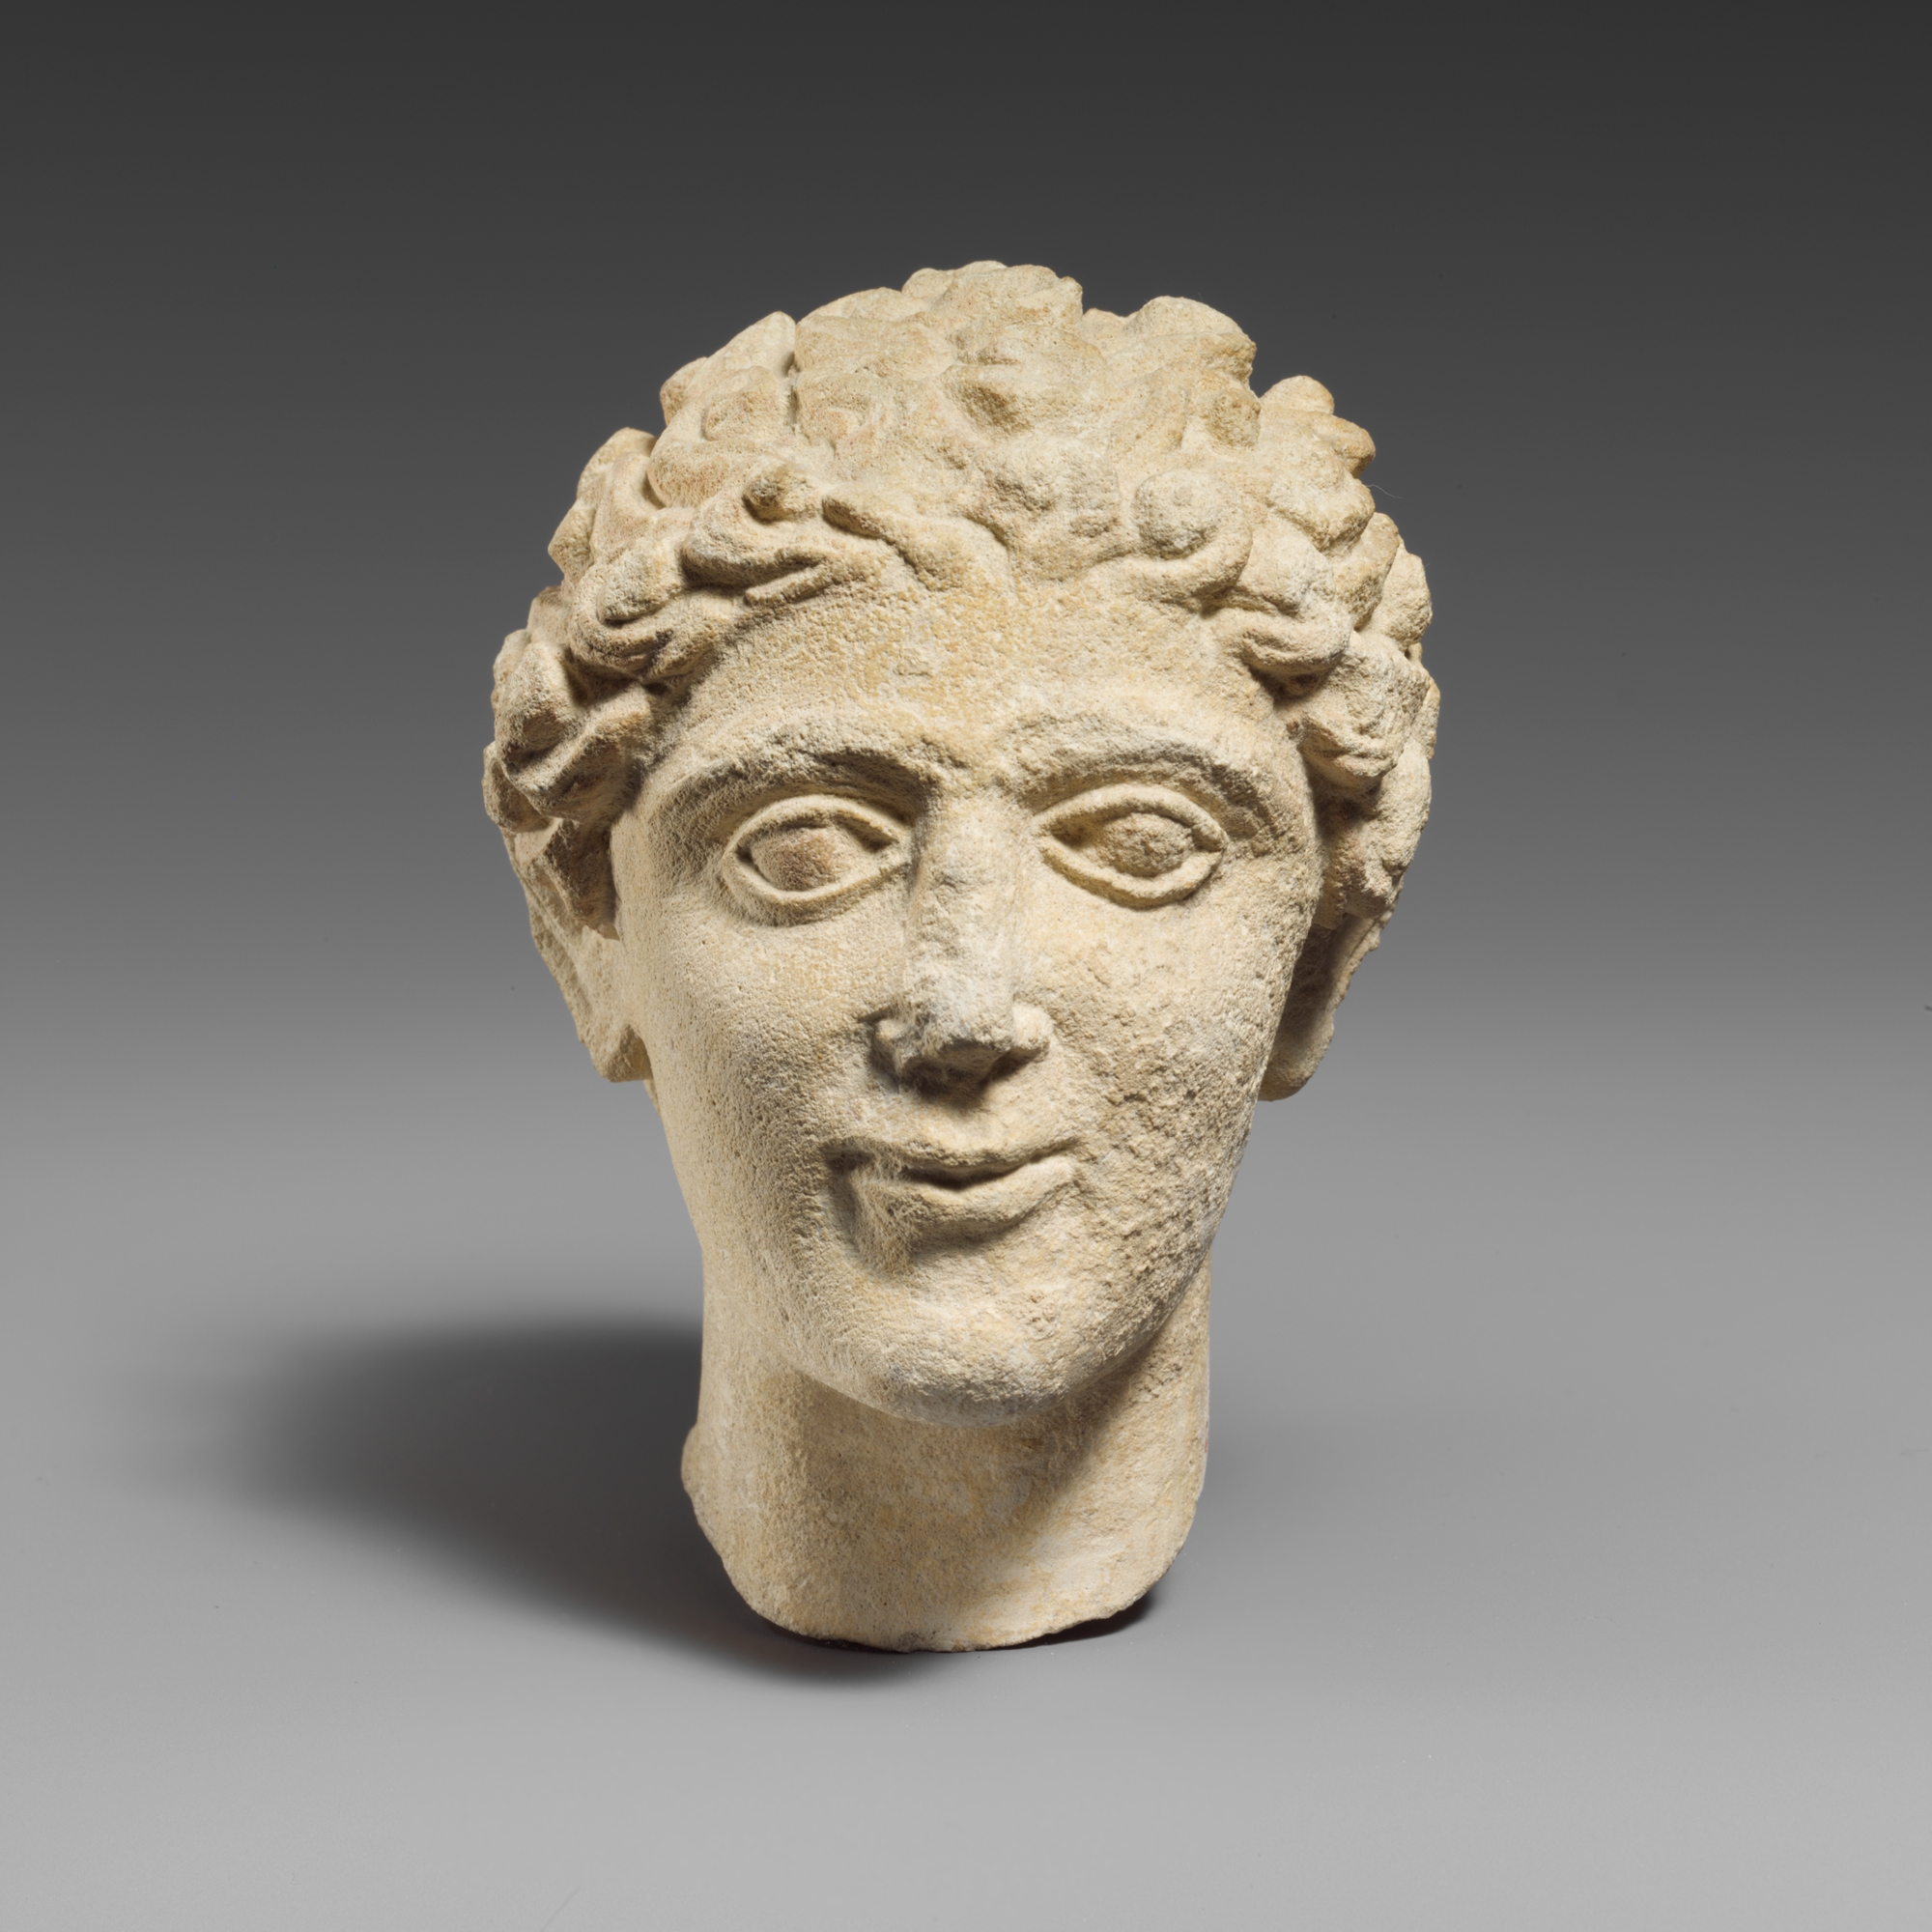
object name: head of a male votary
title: Limestone head of a beardless male votary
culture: cypriot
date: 450-426 BCE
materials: limestone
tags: heads,men